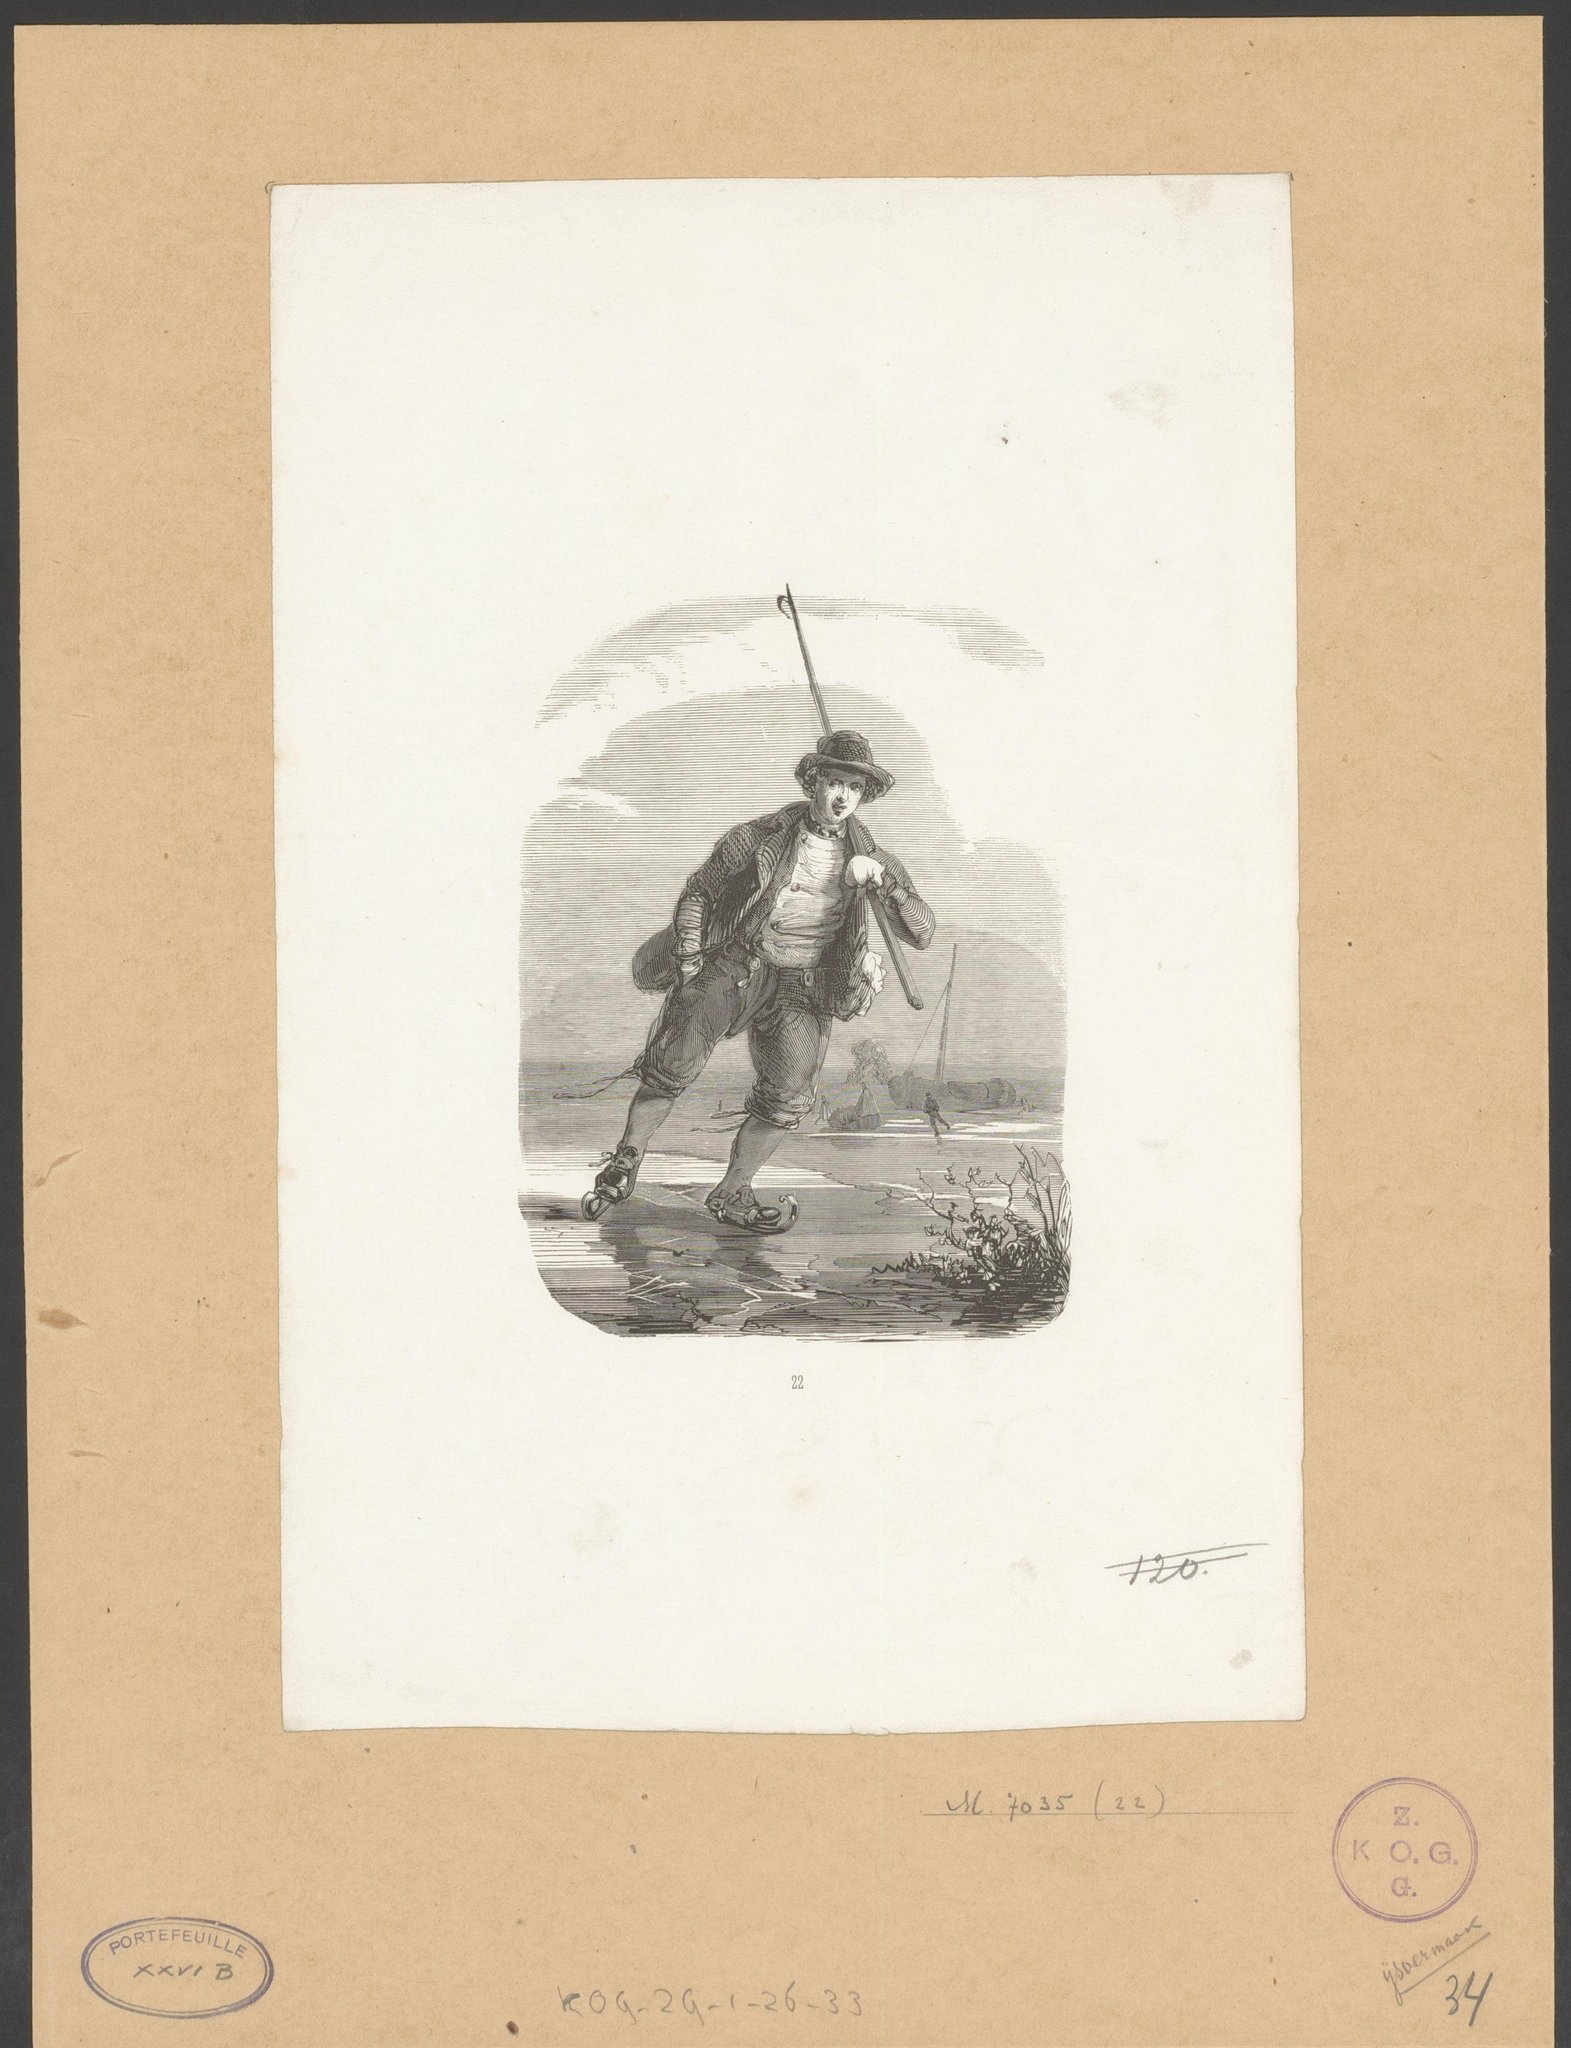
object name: book illustration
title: De schaatsenrijder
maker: henry brown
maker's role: print maker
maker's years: 1816-1870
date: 1841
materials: paper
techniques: engraving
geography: the hague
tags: ice ~ freezing weather, skates (winter sports), severe winters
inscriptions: collector's mark: Lugt 1641, collector's mark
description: Gebruikt als illustratie in: De Nederlanden: karakterschetsen, kleederdragten, houding en voorkomen van verschillende standen, 's-Gravenhage : Nederlandsche Maatschappij van schoone kunsten, 1841.